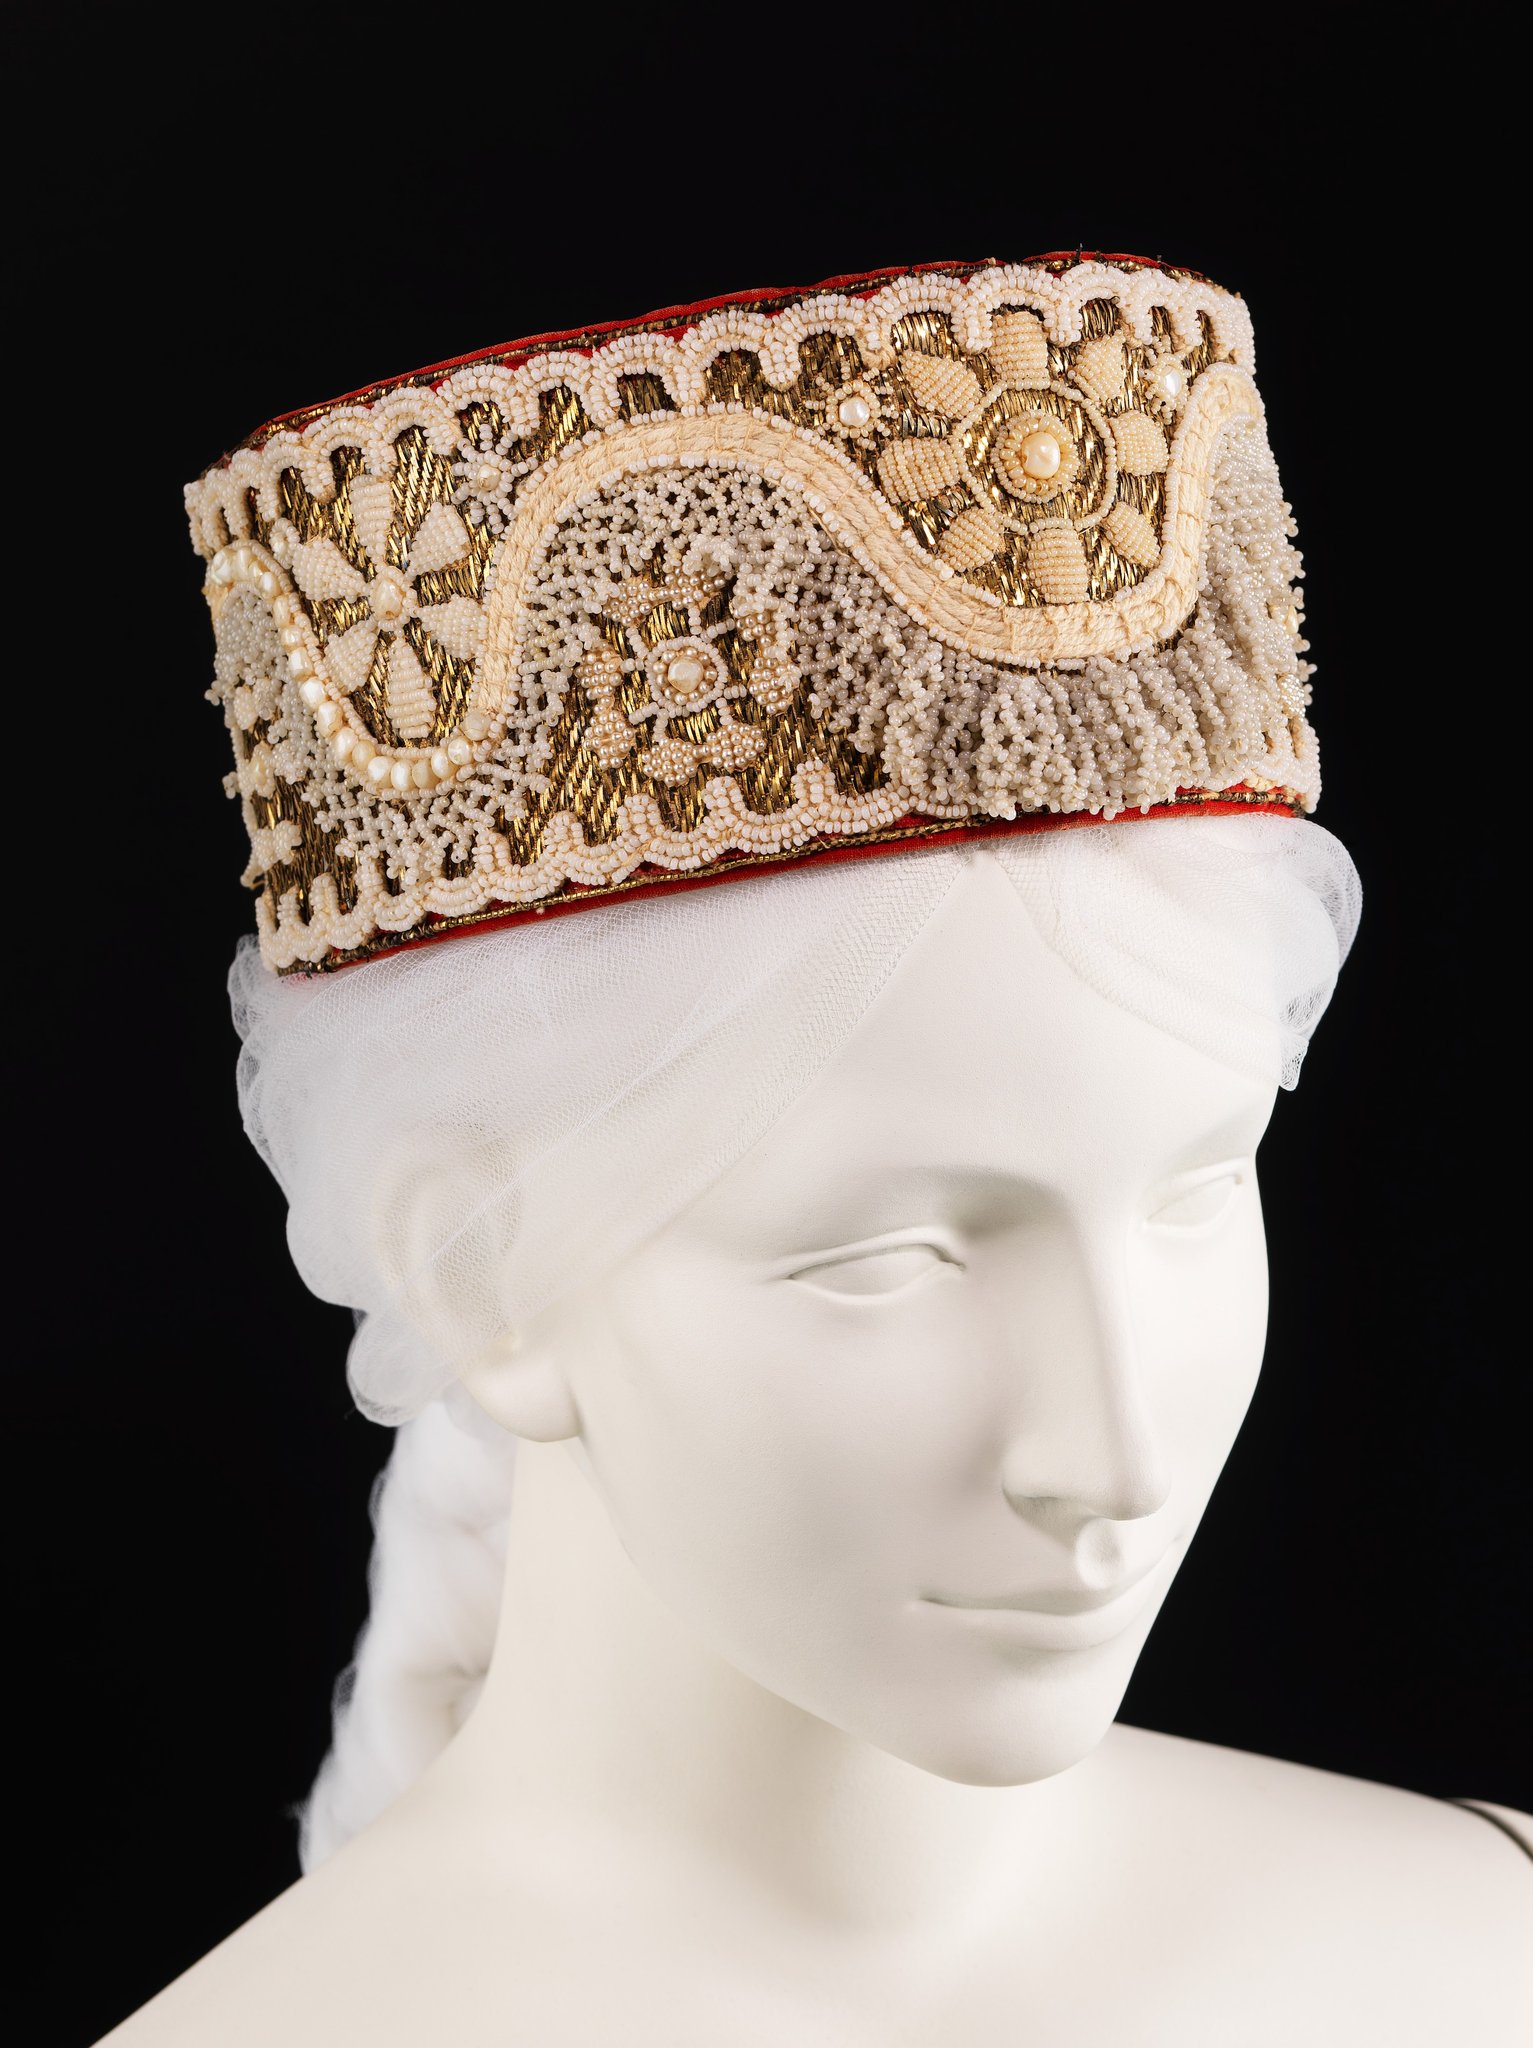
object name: headdress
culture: russian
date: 1801-1833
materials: cotton, glass, metal, mother of pearl